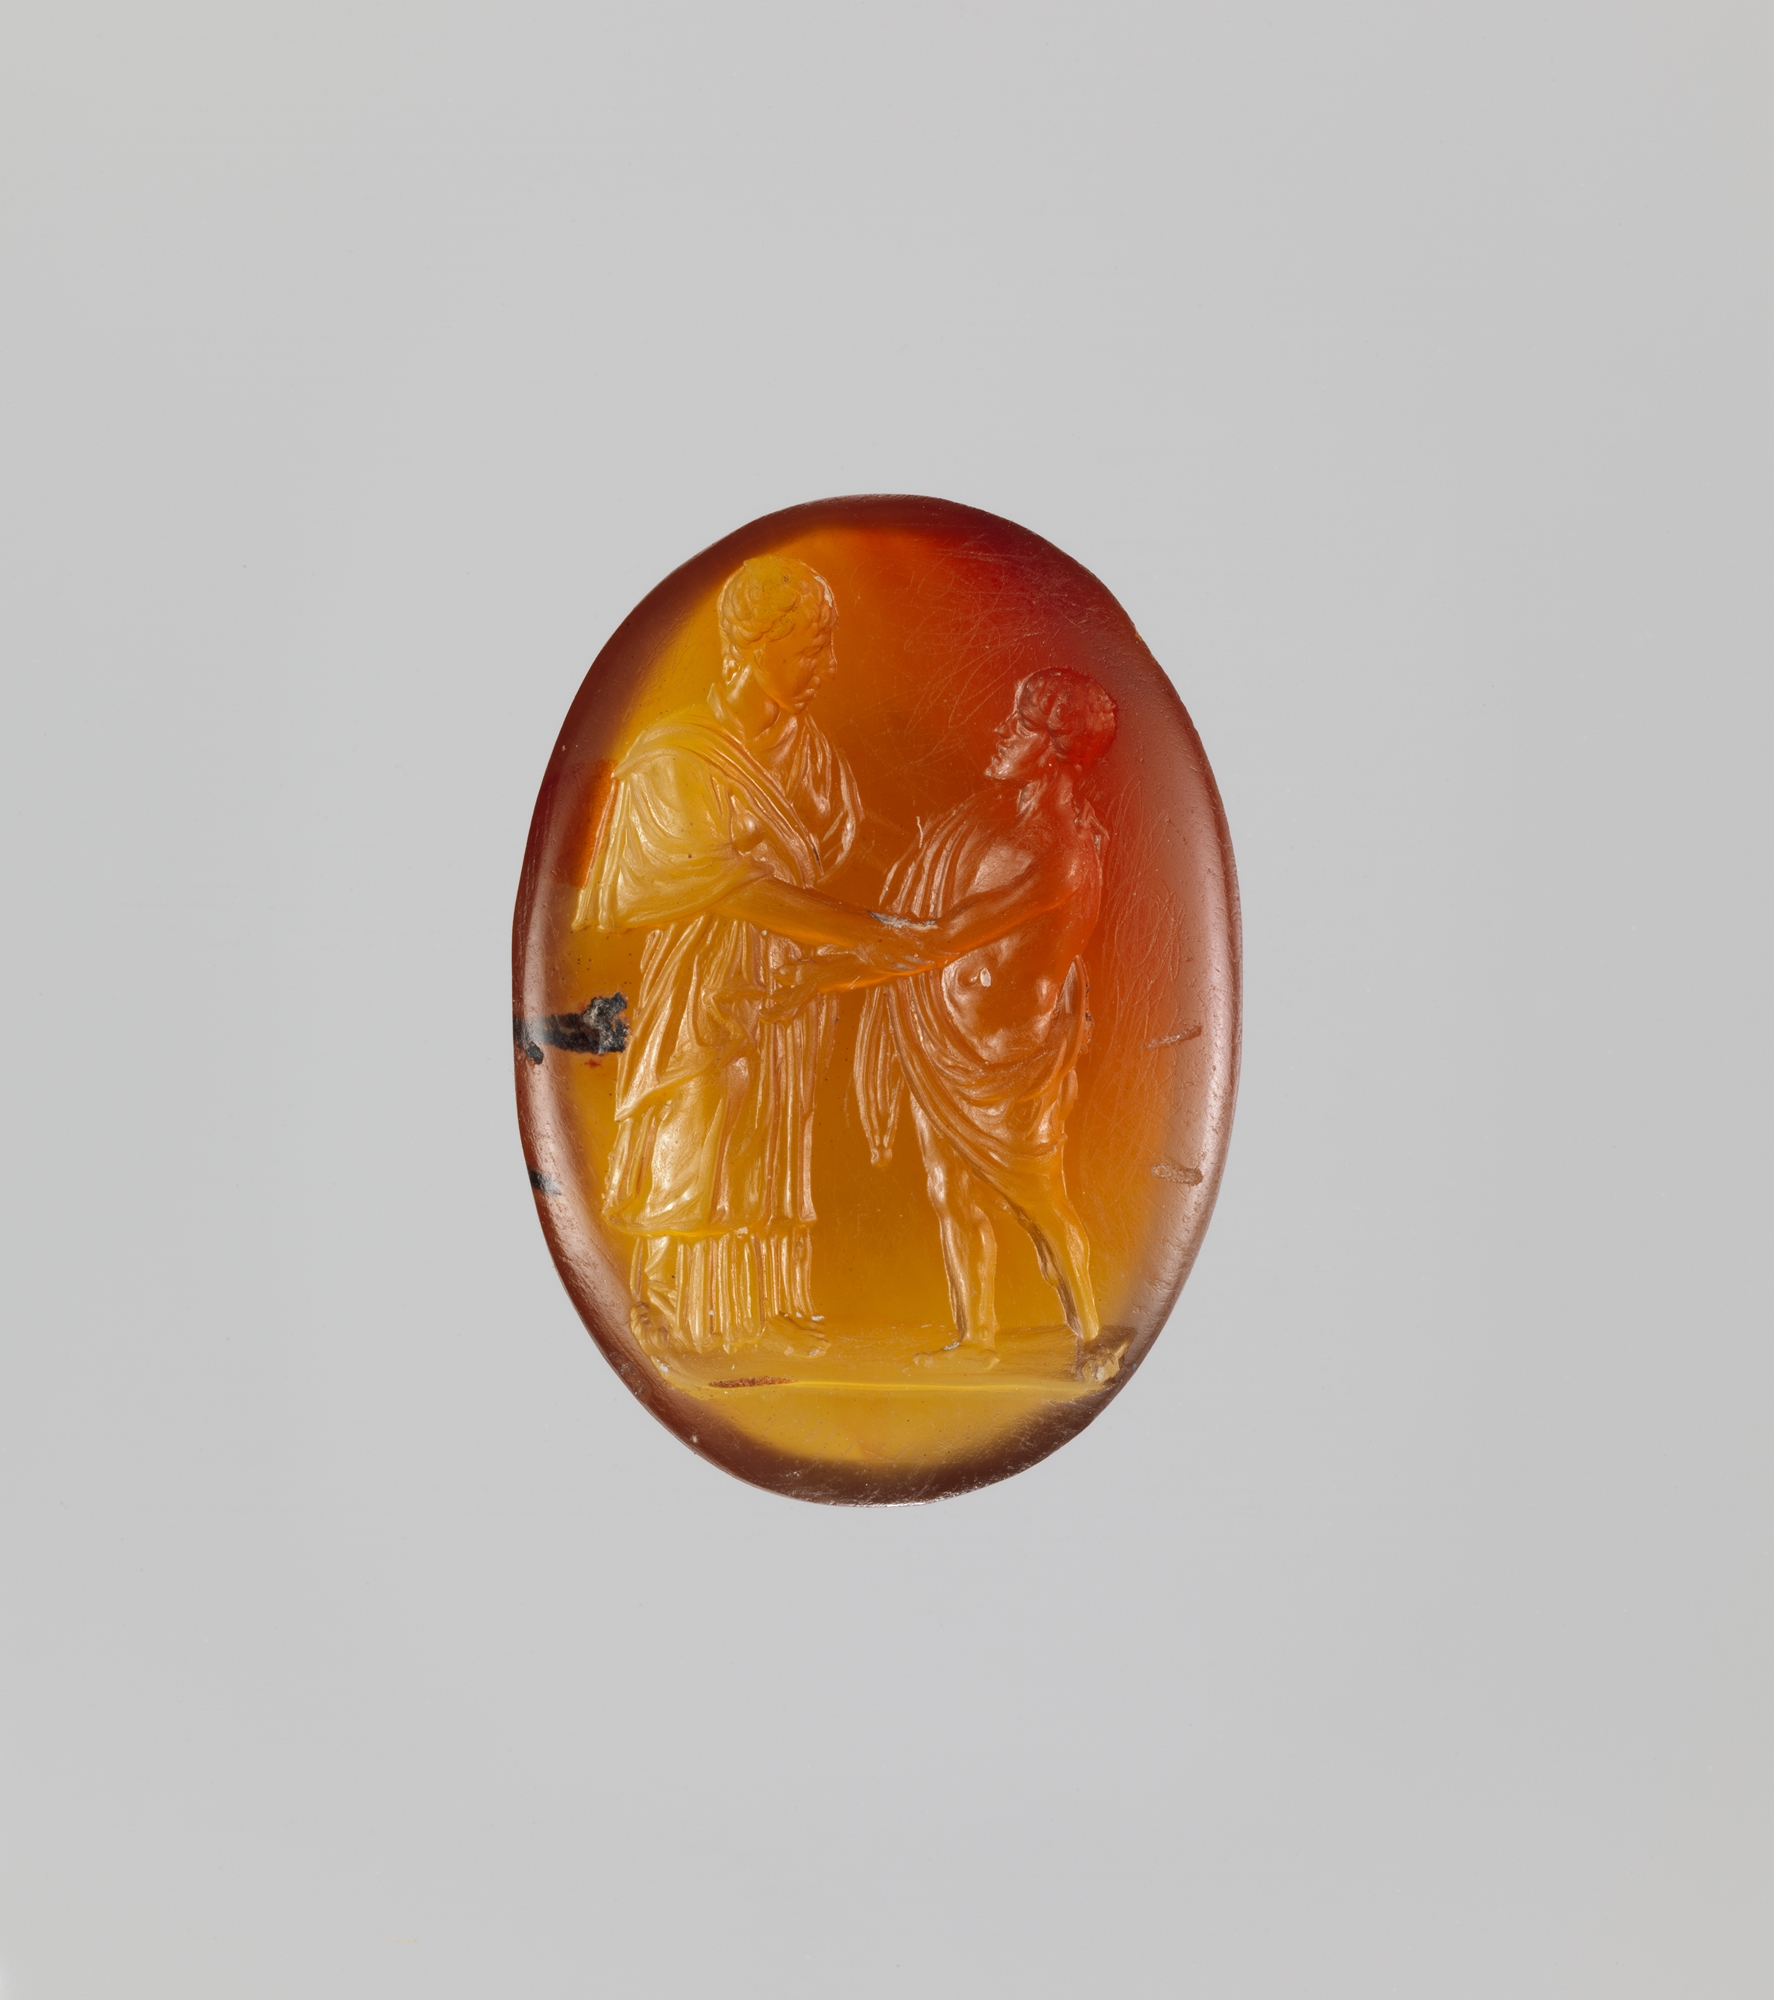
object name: intaglio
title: Carnelian ring stone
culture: post-classical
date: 7000 BCE-330 CE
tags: men